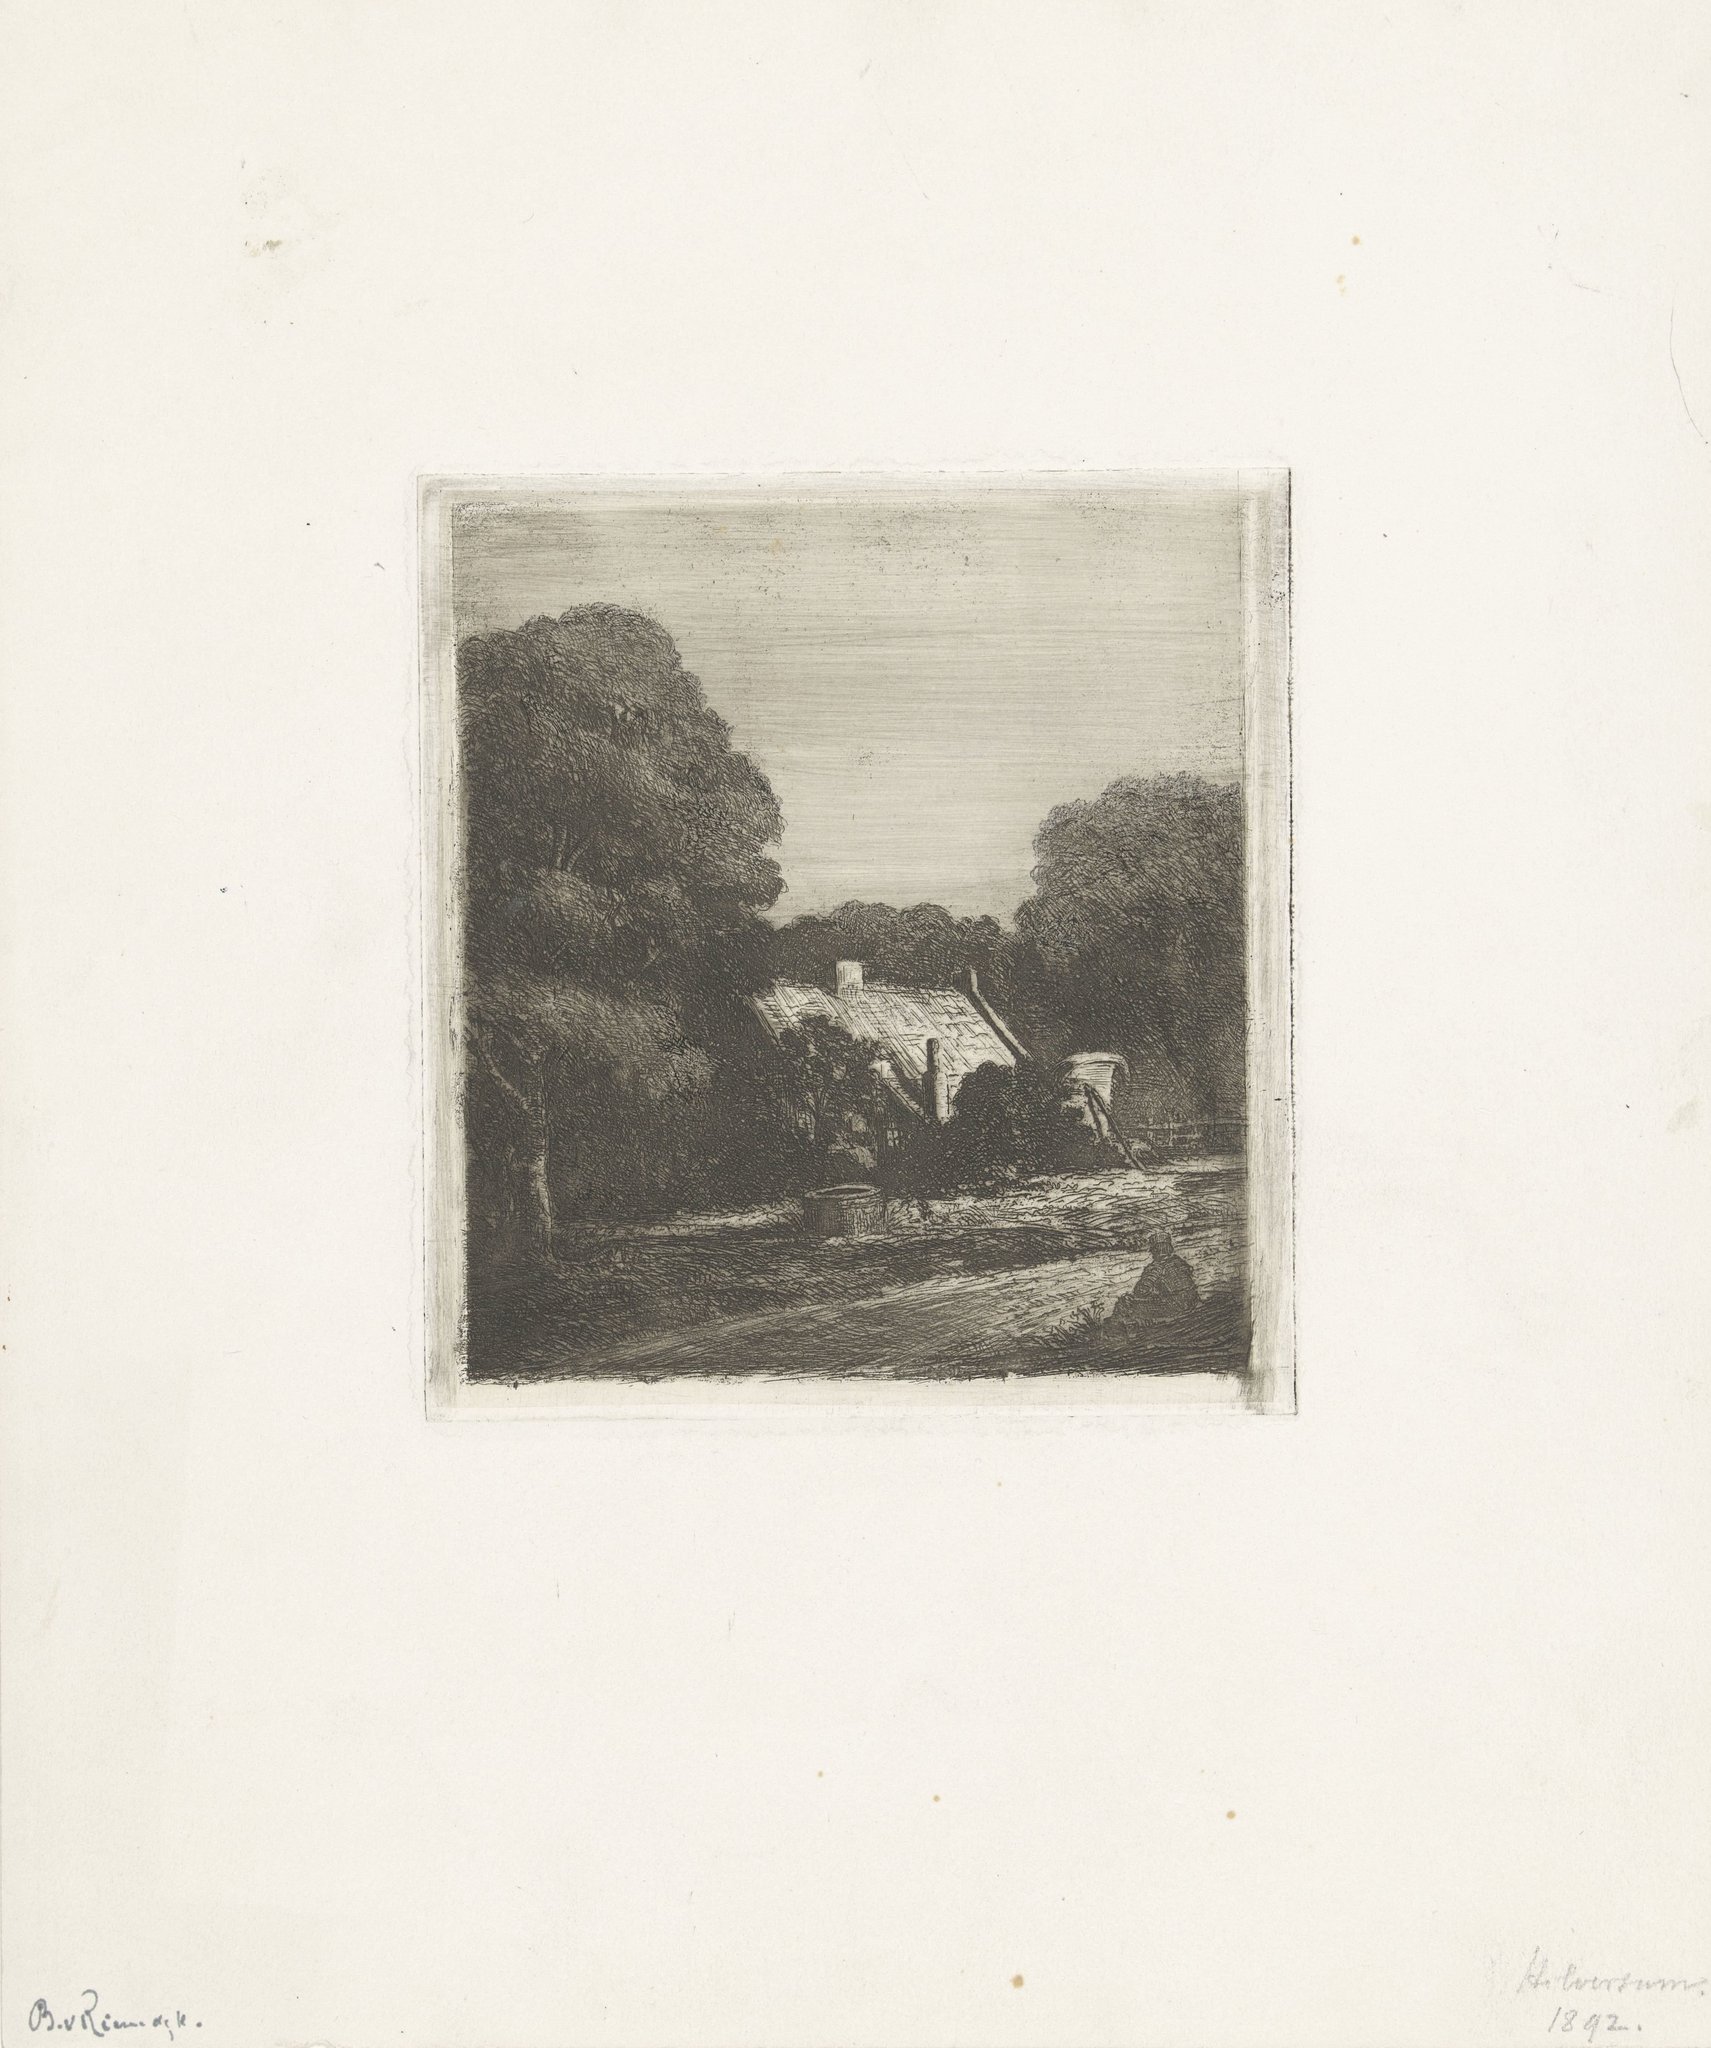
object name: print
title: Landweg bij Hilversum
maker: jonkheer barthold willem floris van riemsdijk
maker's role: engineer, print maker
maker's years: 1850-1942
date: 1892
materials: paper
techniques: drypoint, etching, intaglio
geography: netherlands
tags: road, path, farm or solitary house in landscape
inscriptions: collector's mark: Lugt 2228, inscription: ‘B. v Riemsdijk Hilversum 1892’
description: Aan een landweg bij Hilversum ligt een huis dat wordt overschaduwd door geboomte. Op de voorgrond zit een man aan de rand van de weg.